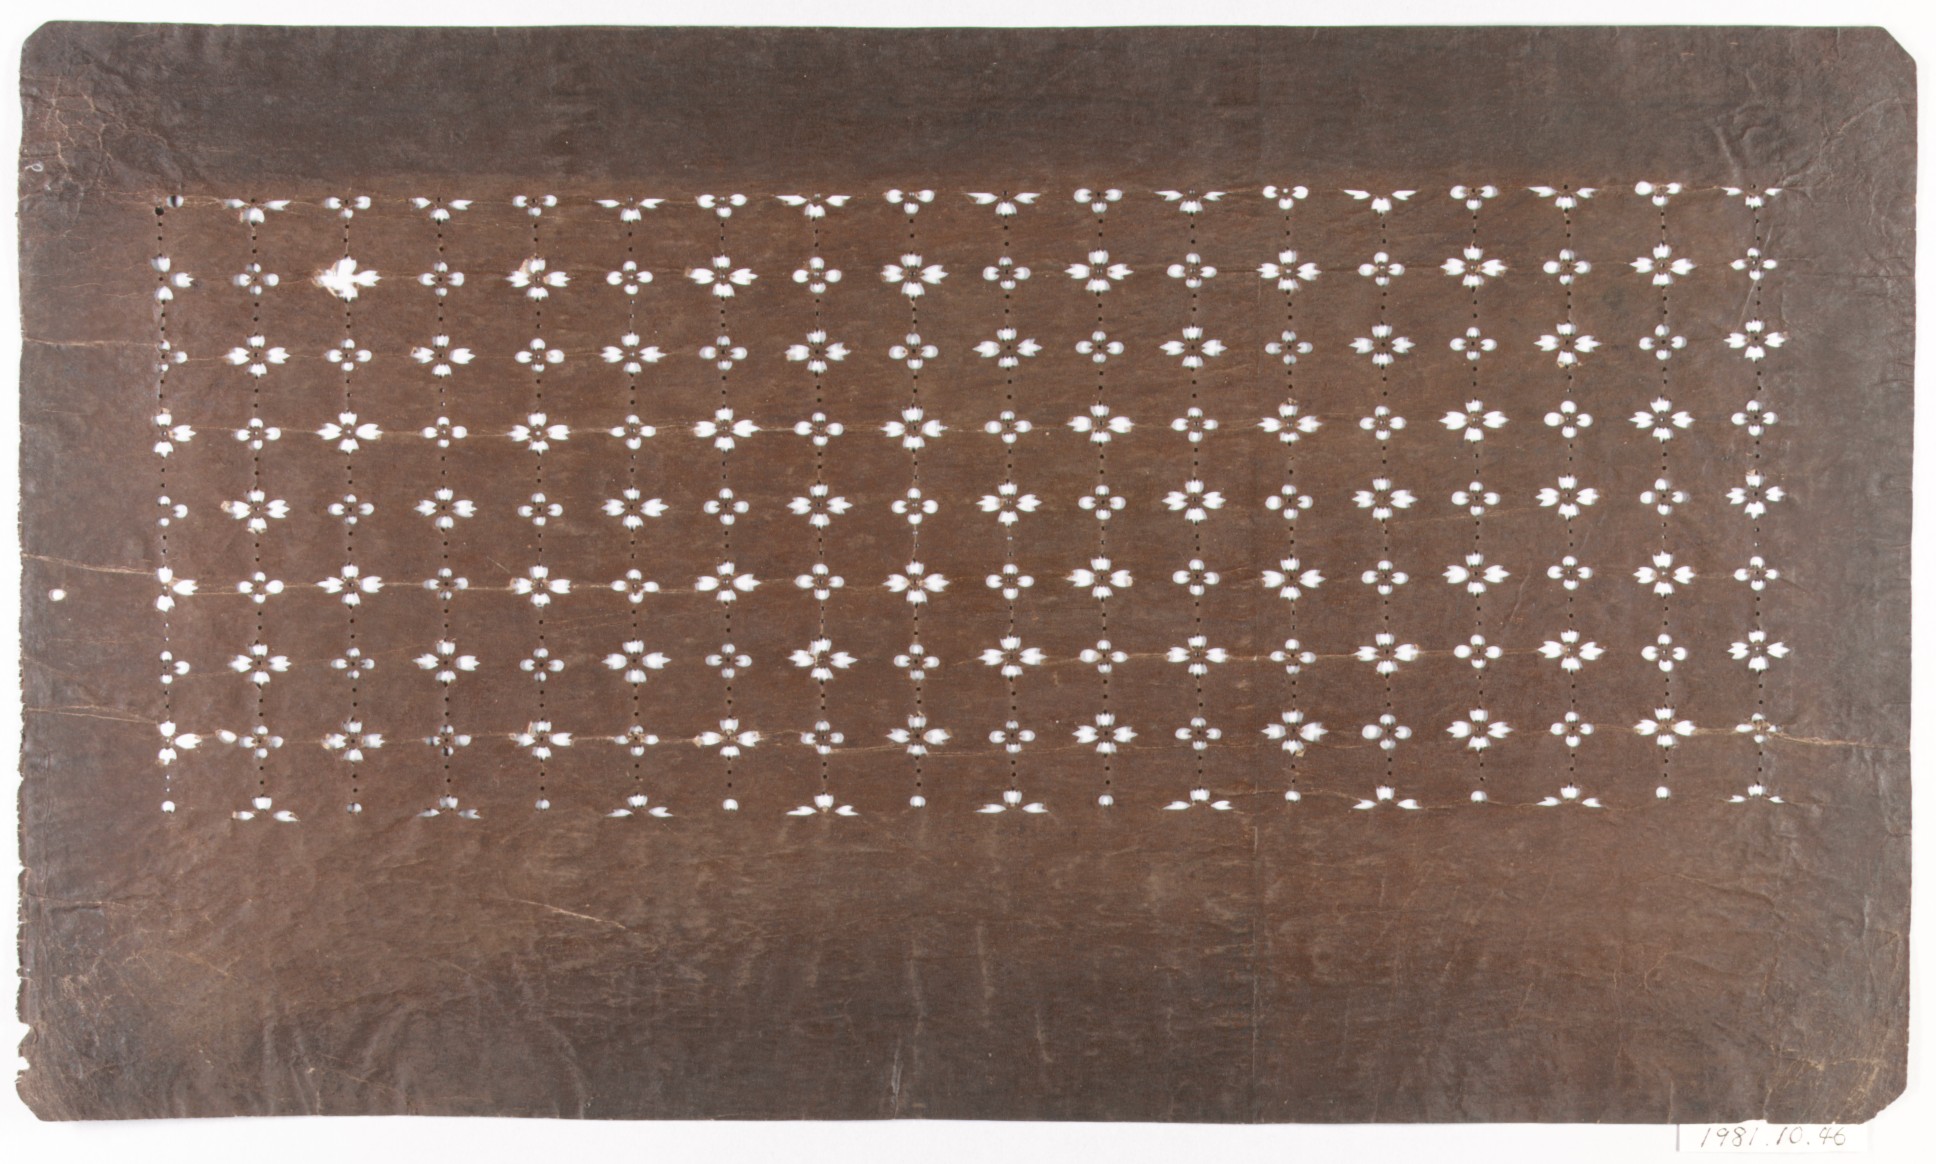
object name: stencil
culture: japanese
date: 1801-1900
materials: paper